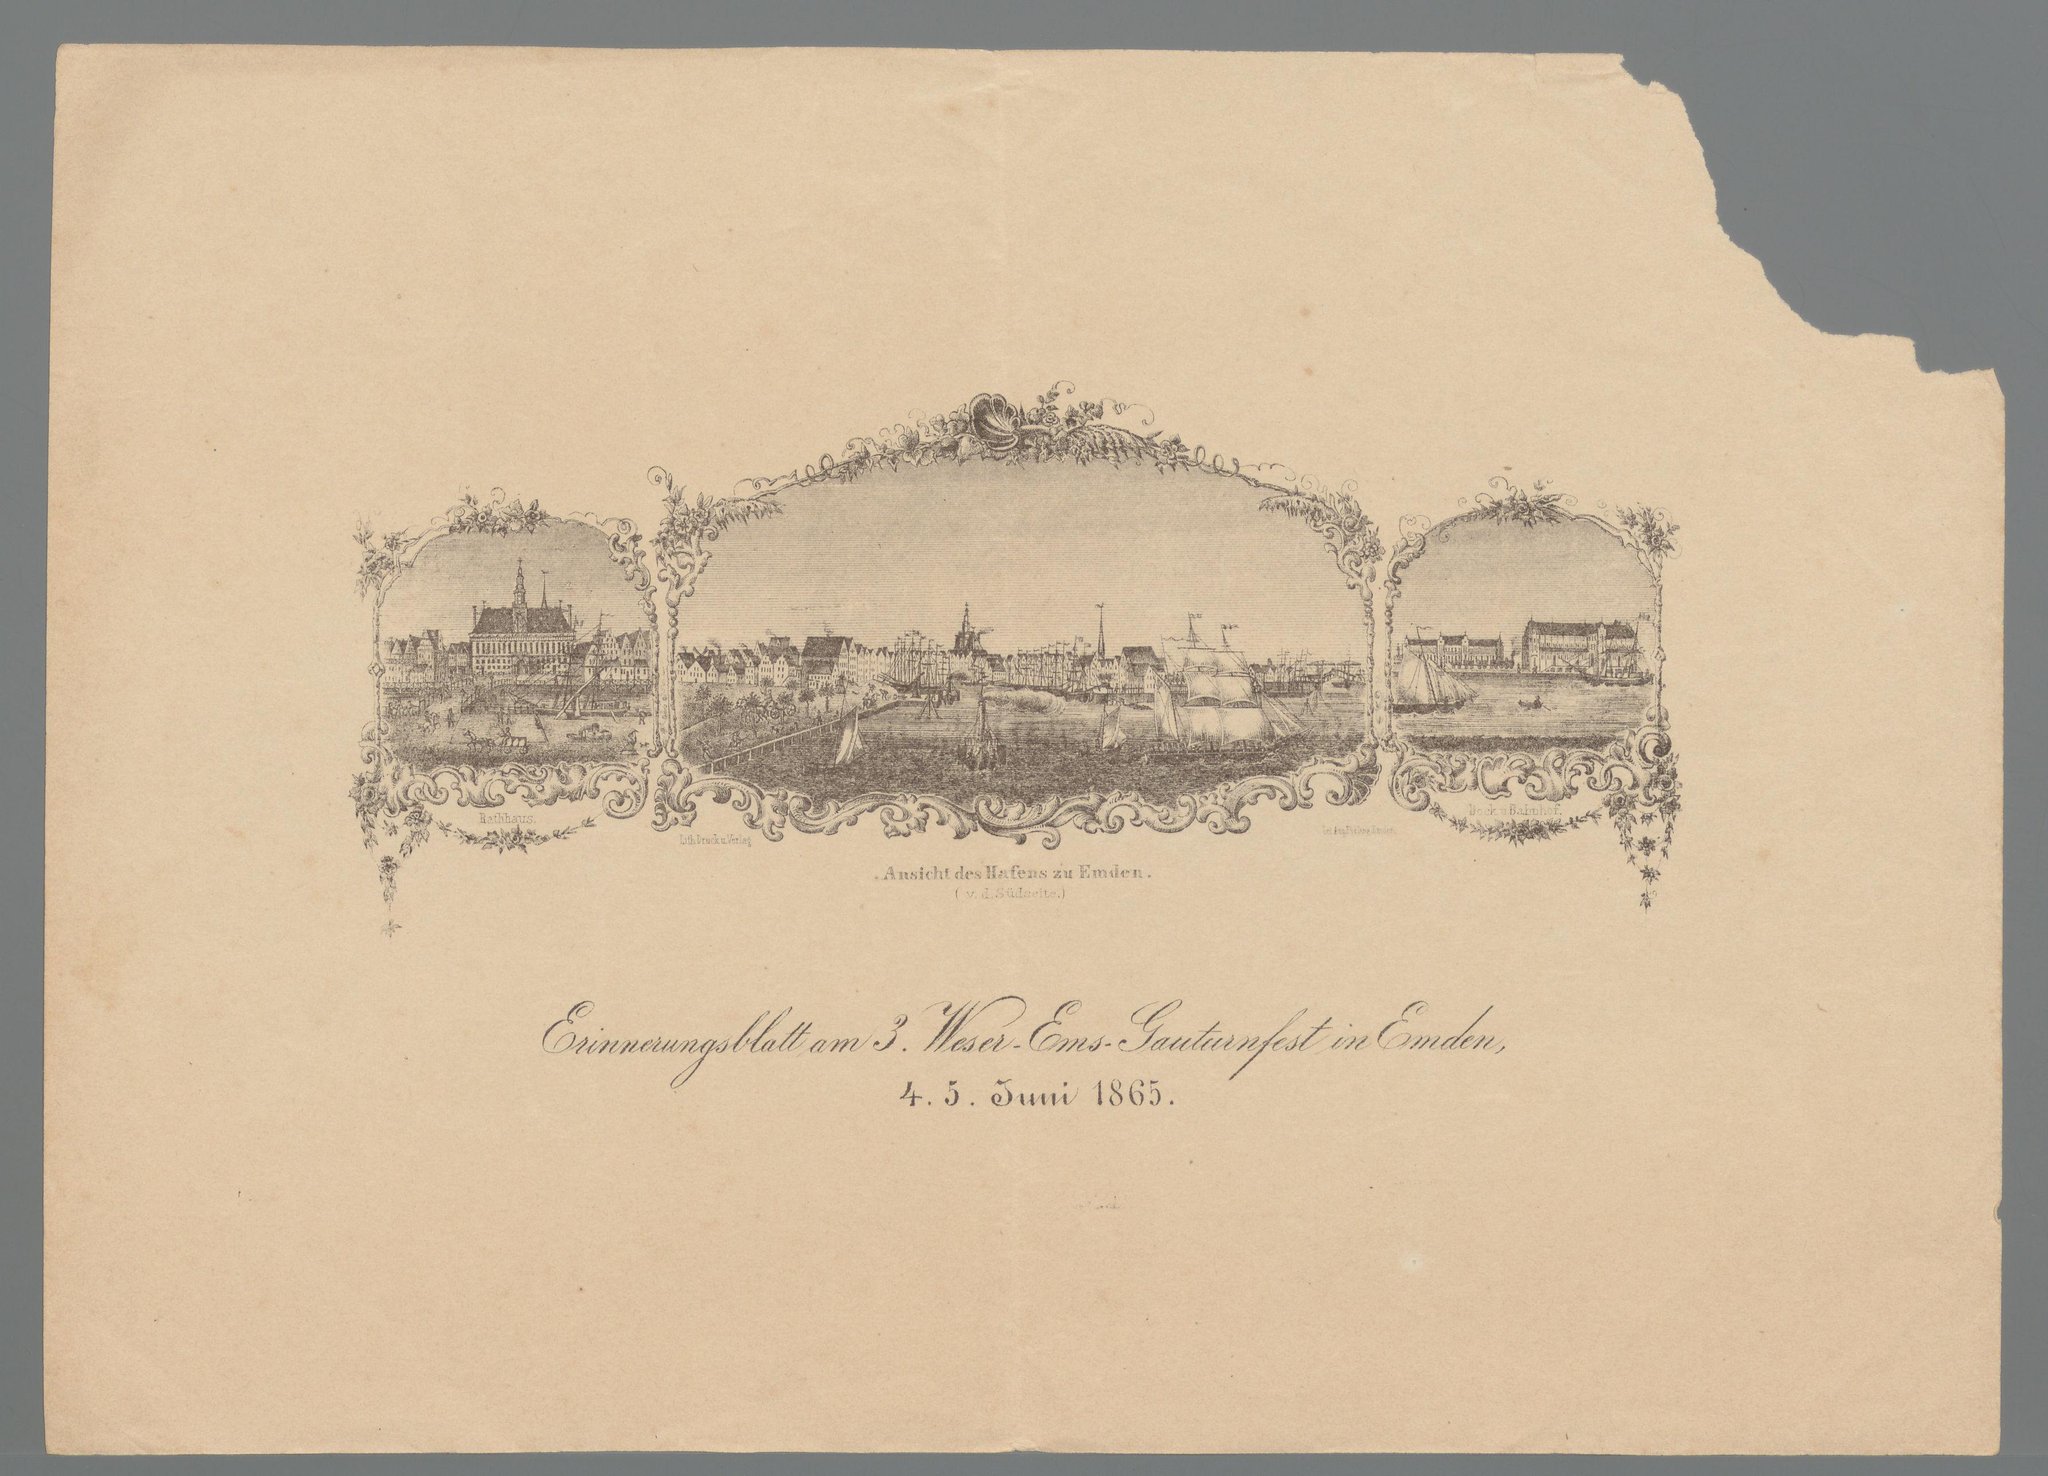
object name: print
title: Gezicht op de haven te Emden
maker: august ebeling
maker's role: print maker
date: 1865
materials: paper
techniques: lithograph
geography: emden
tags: harbour, sailing-ship, sailing-boat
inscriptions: collector's mark: Lugt 2228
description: De prent is een herinnering aan het derde Weser-Ems-Gauturnfest te Emden op vier en vijf juni 1865.